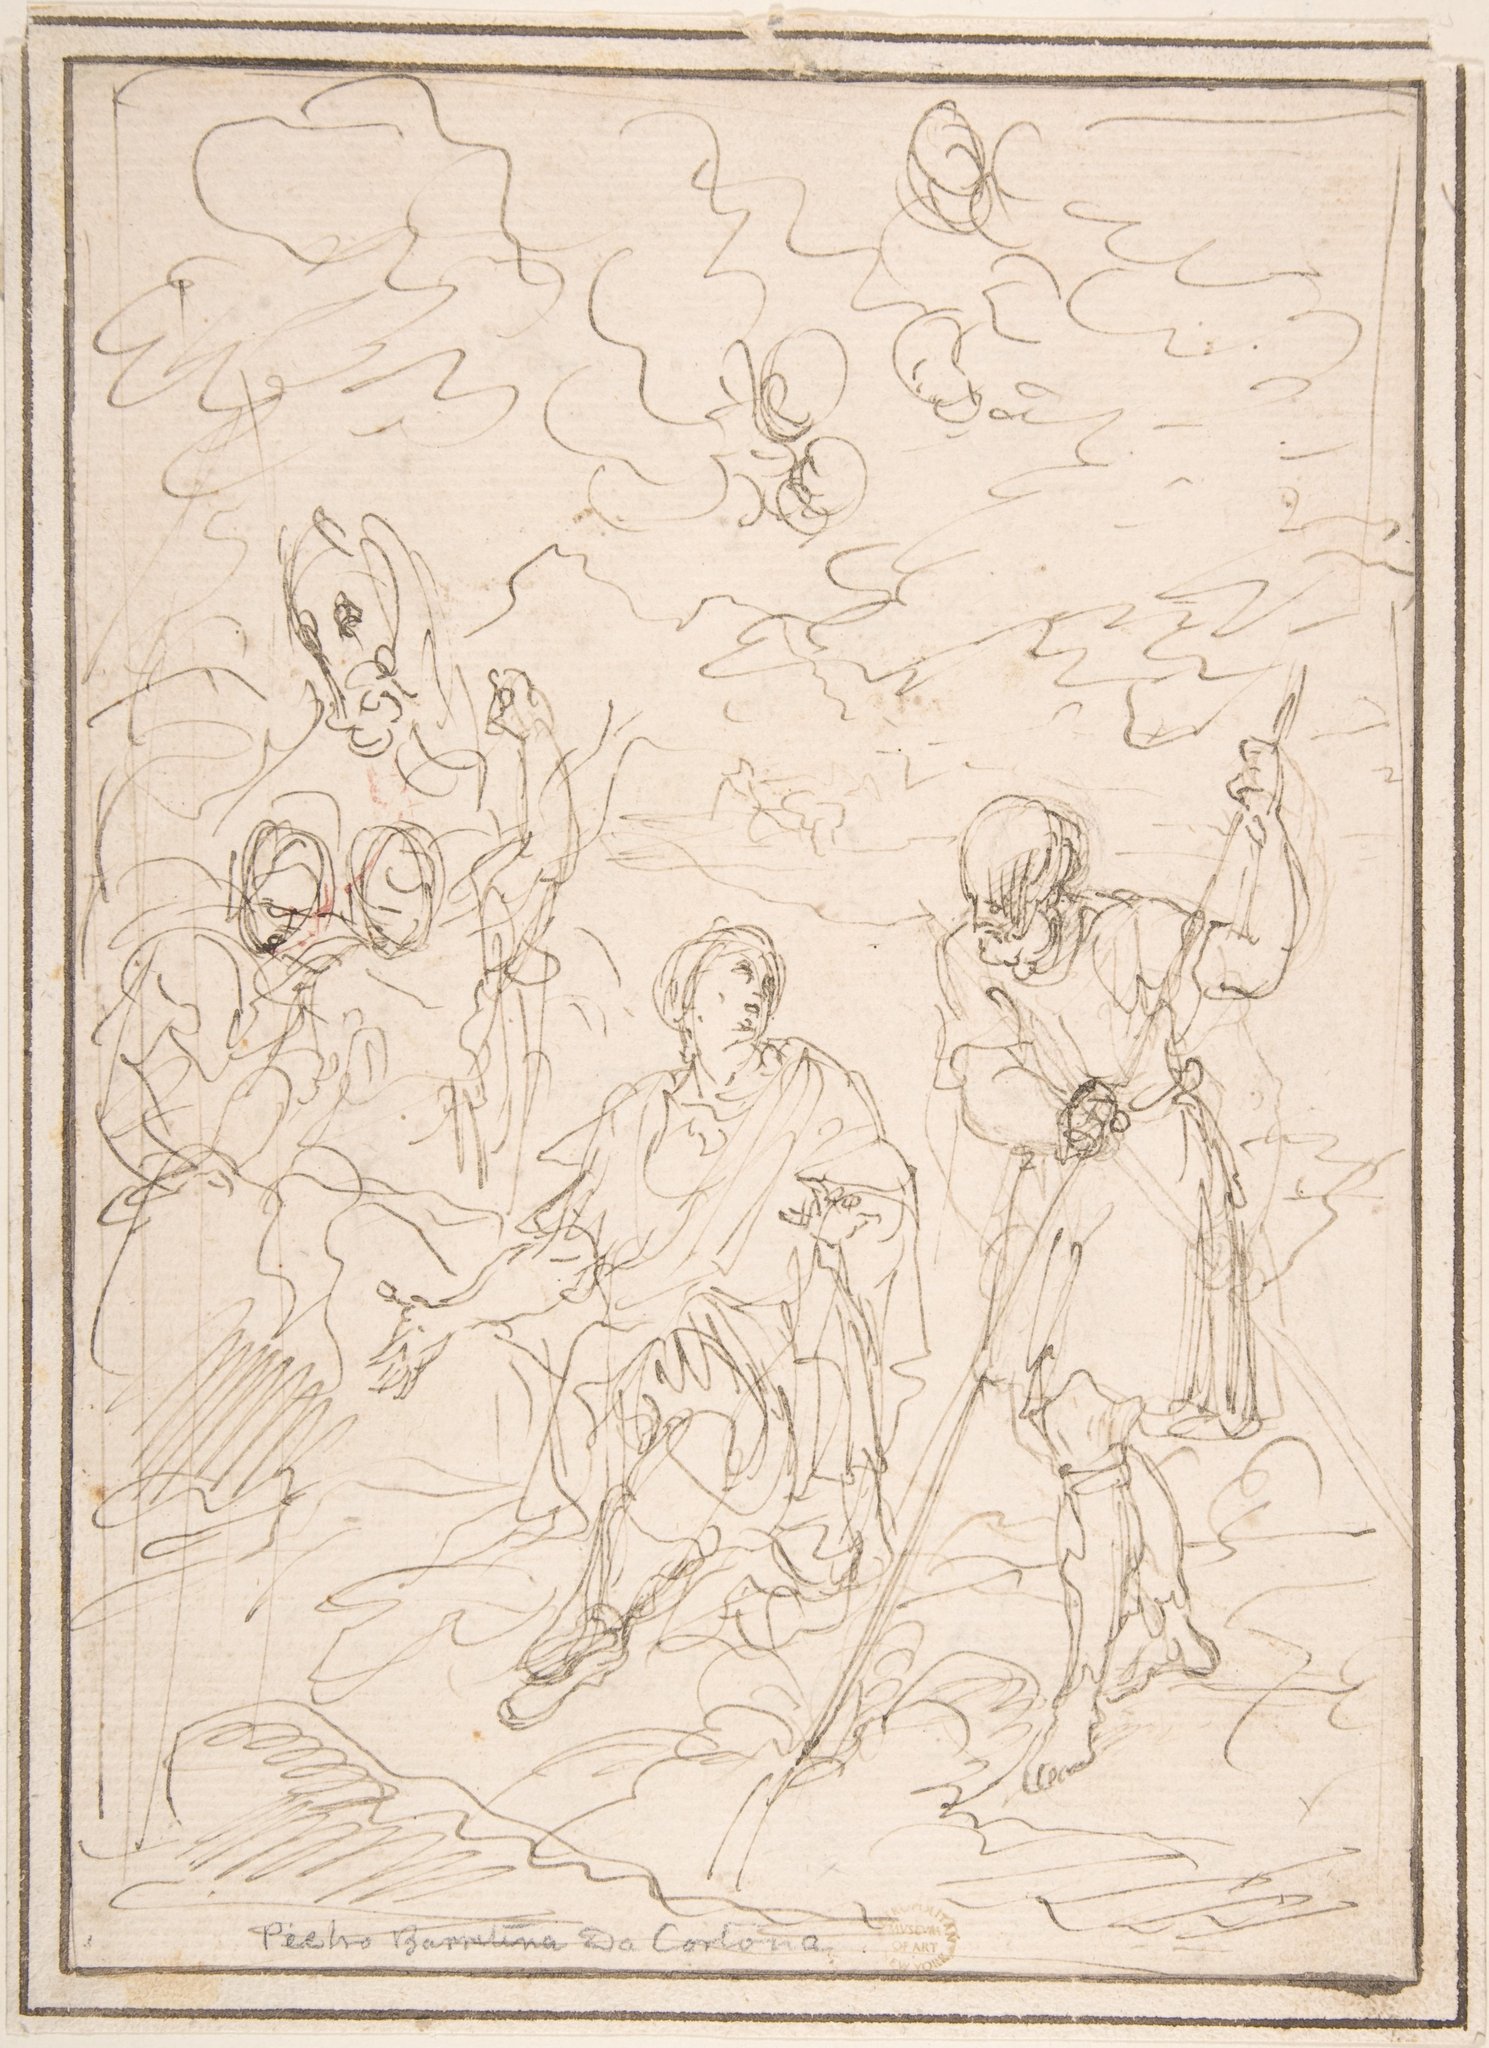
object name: drawing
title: Study for a Picture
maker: anonymous, italian, roman-bolognese, 17th century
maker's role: artist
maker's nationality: italian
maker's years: 1600-1700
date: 1601-1700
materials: chalk, ink, paper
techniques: pen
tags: human figures